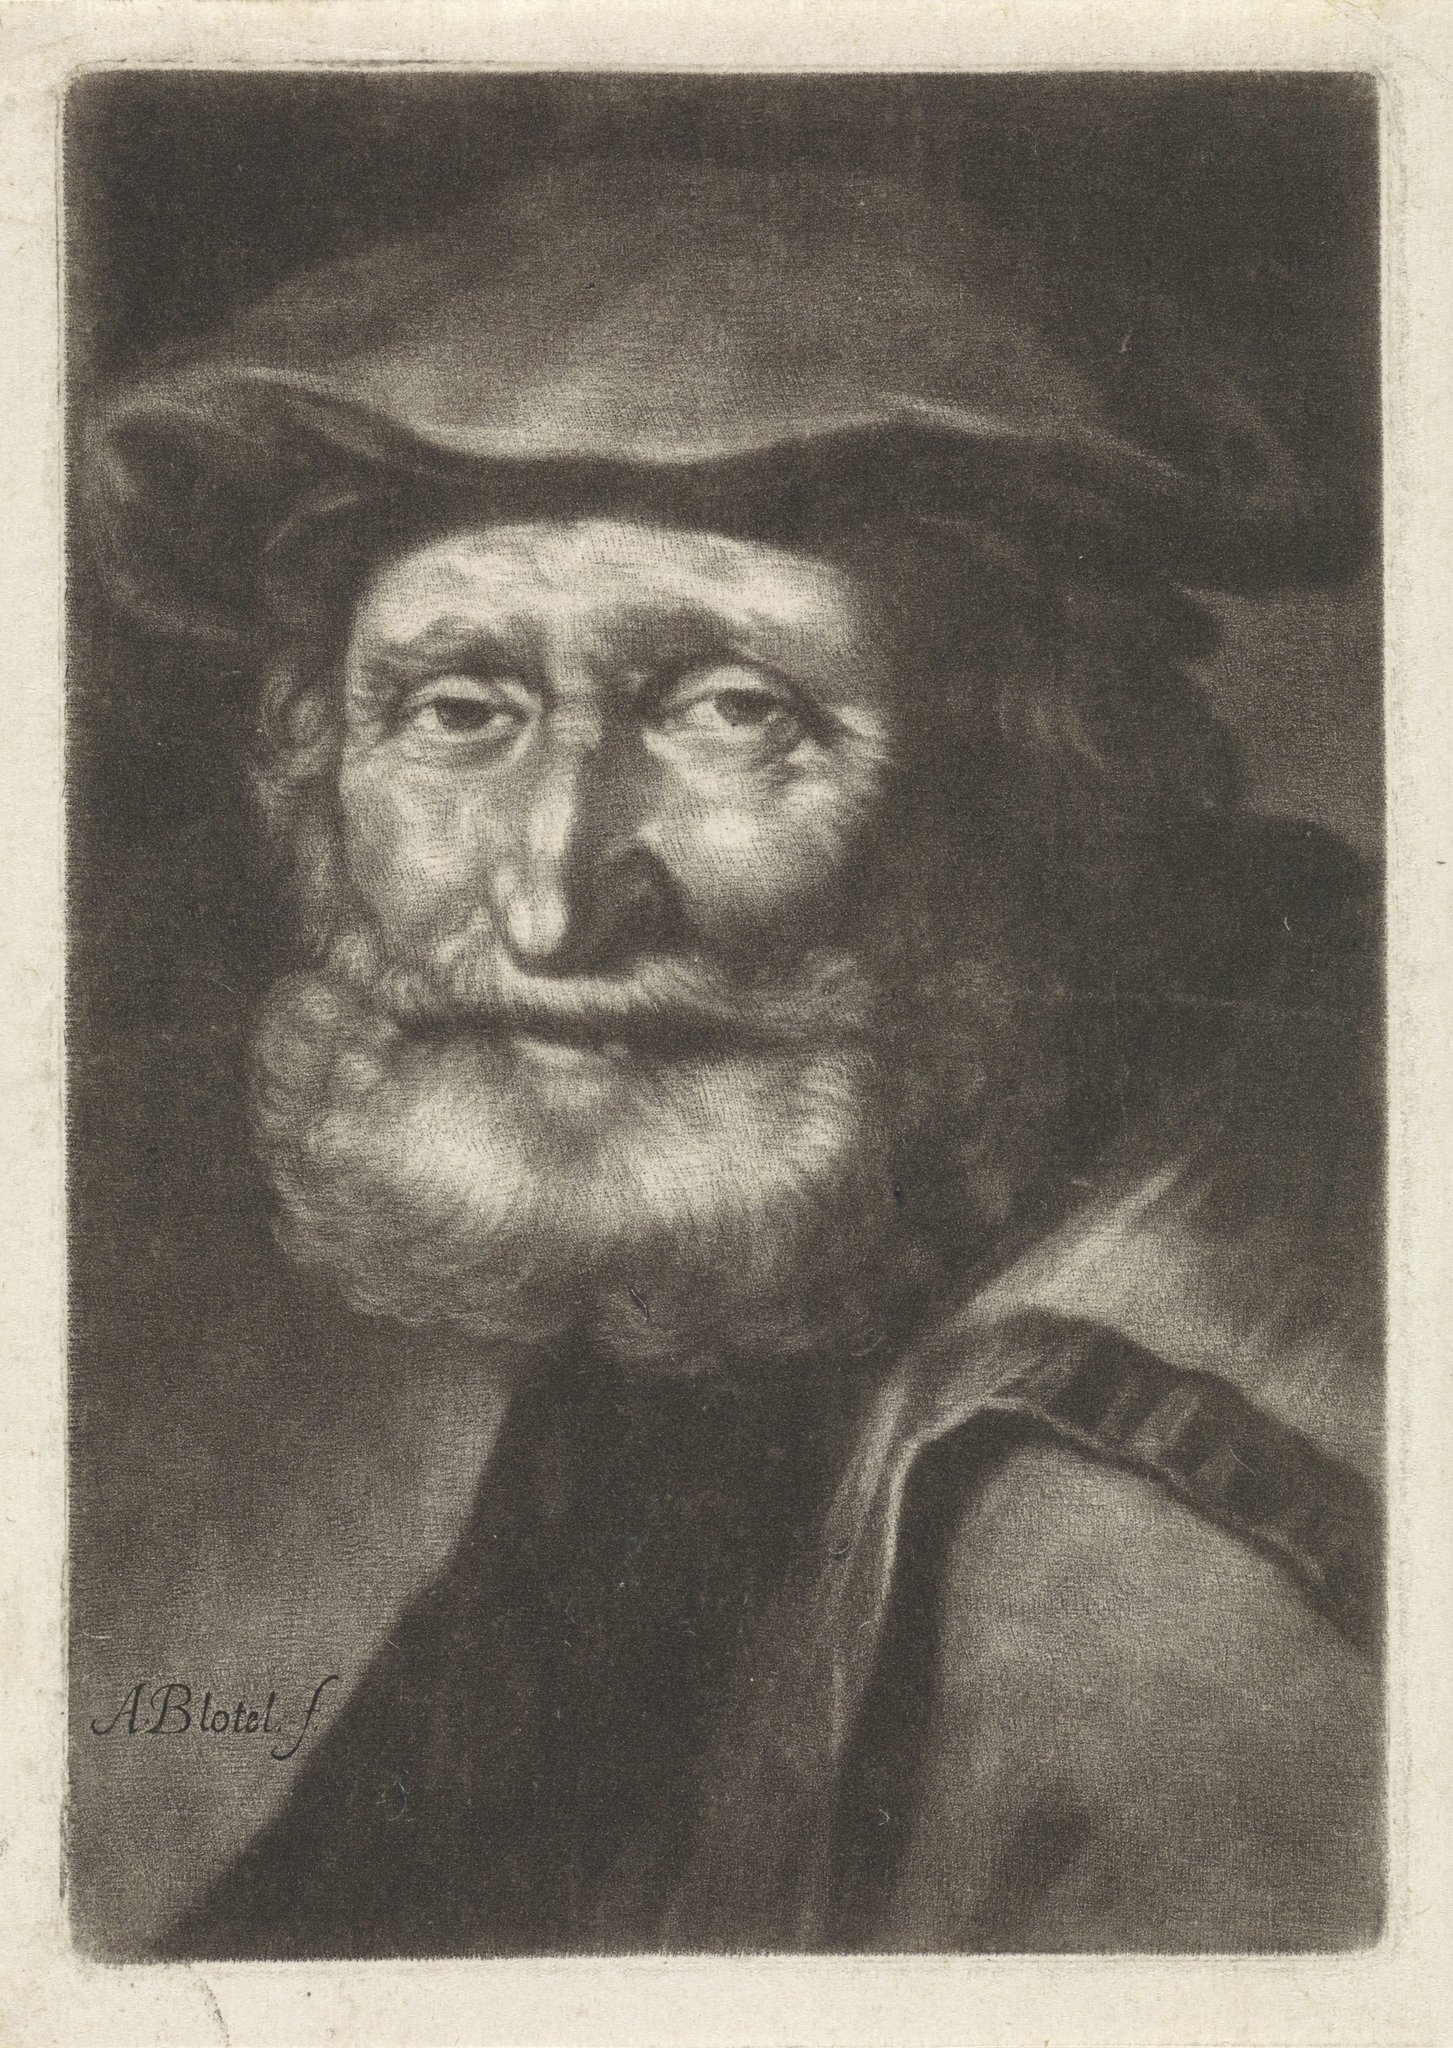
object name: print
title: Buste van een lachende man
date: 1652-1690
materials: paper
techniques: engraving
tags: staverinus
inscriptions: collector's mark: Lugt 2228